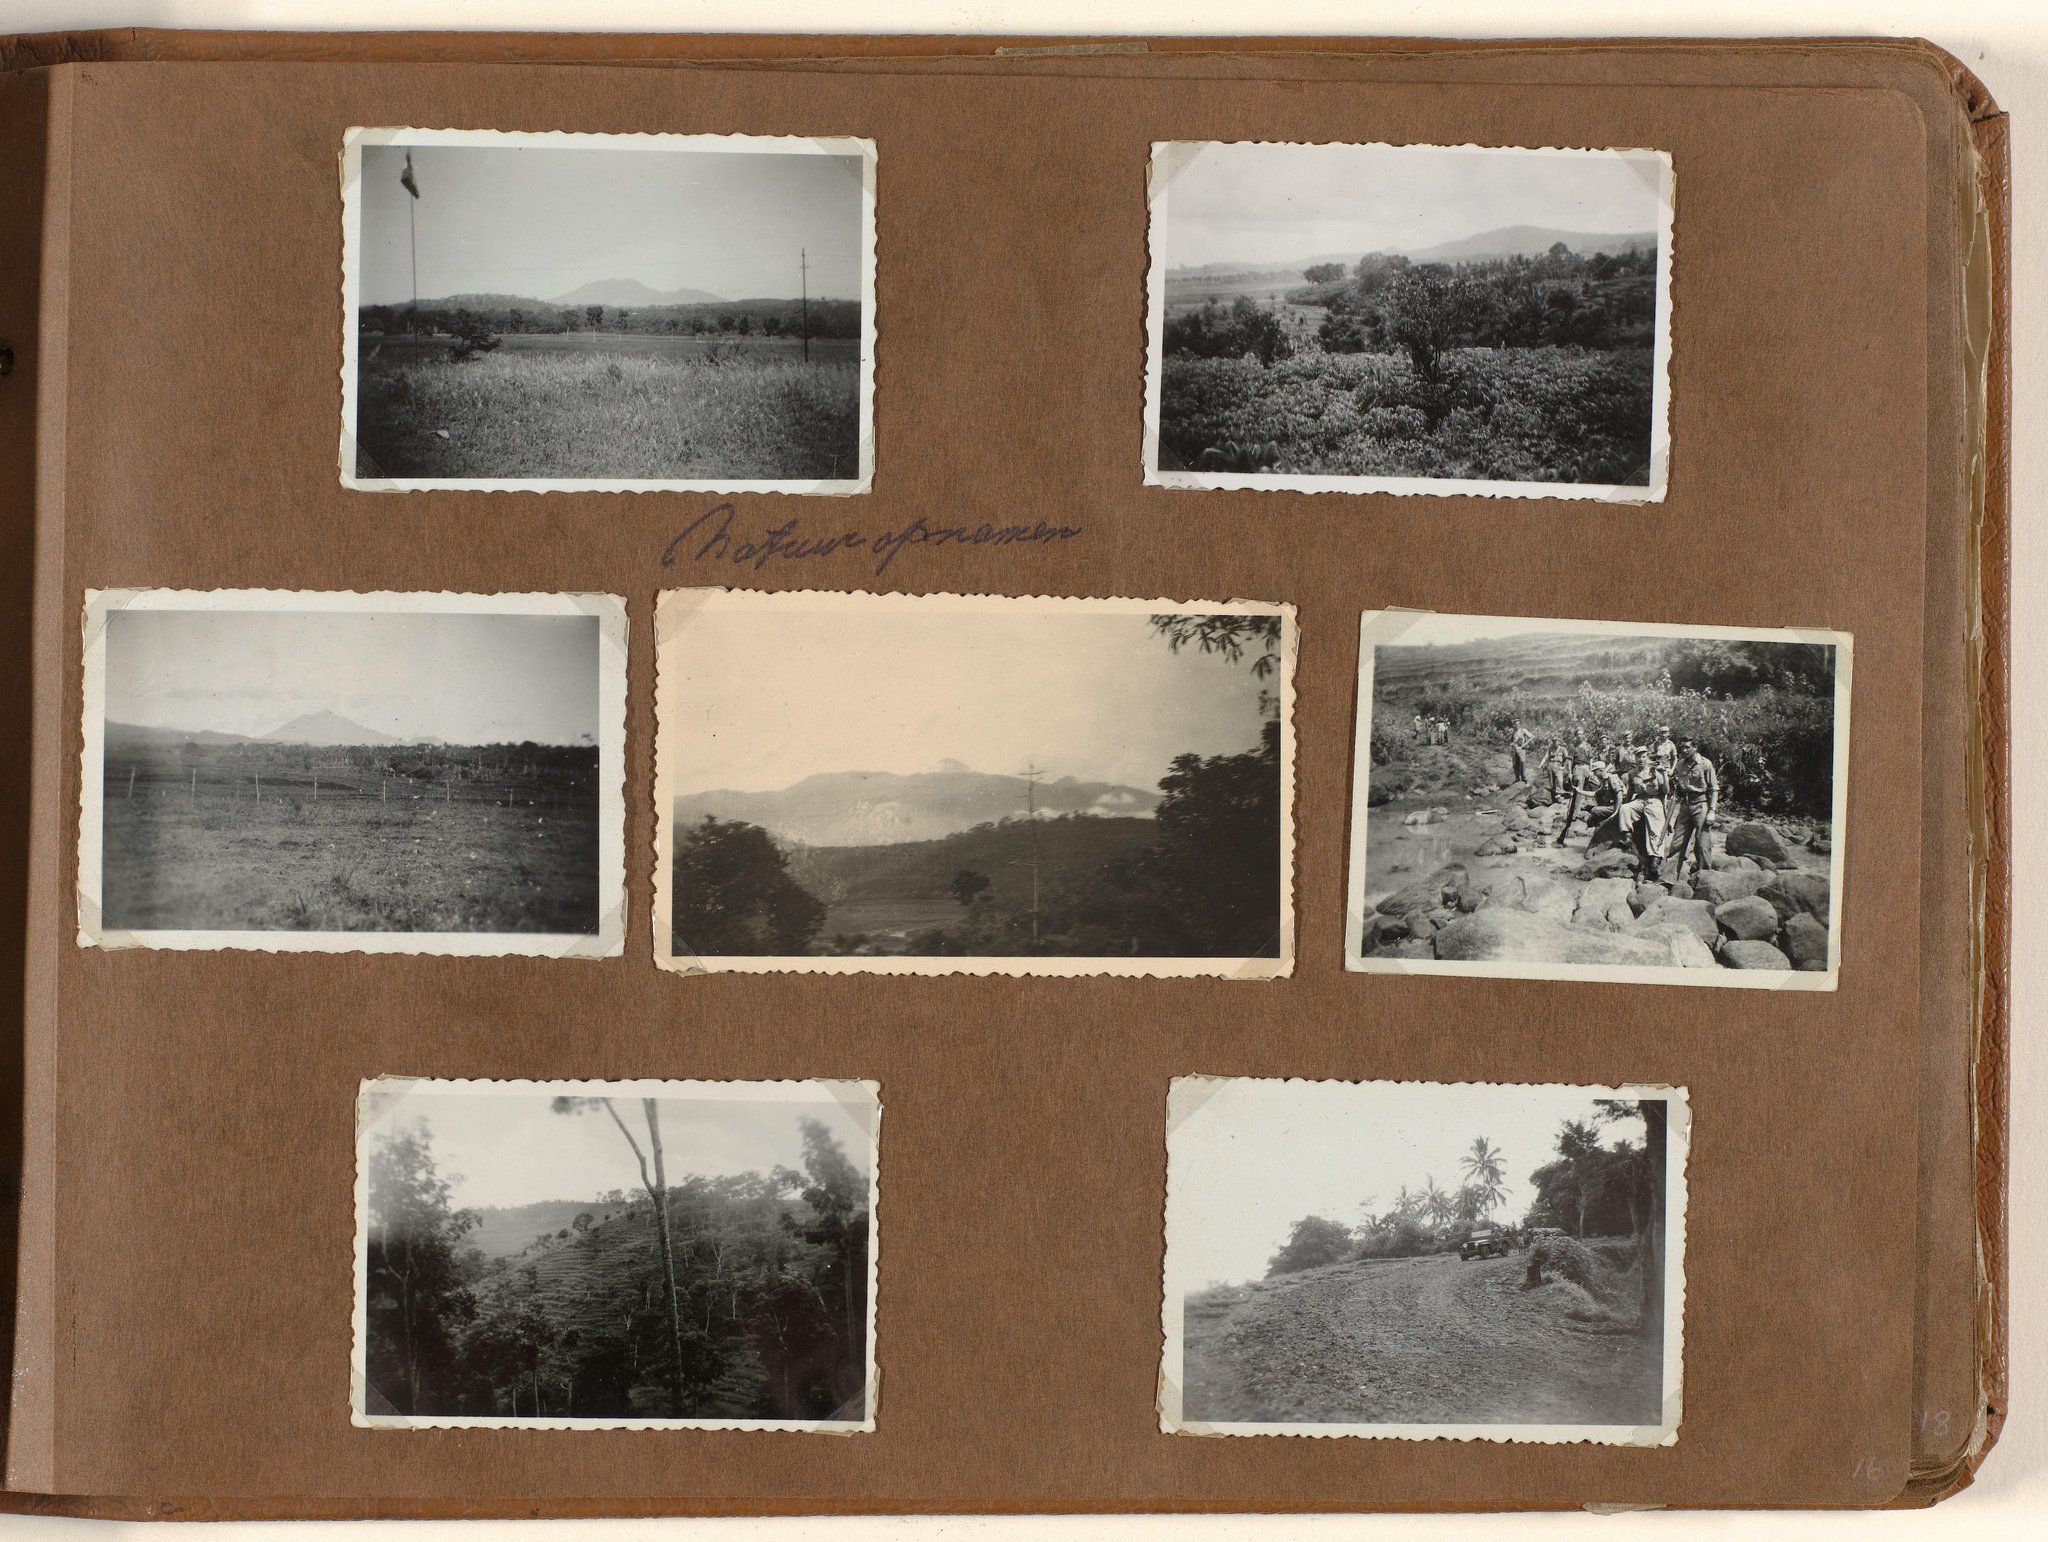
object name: album leaf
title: Natuuropnamen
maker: Anonymous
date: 1948-1949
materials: paper, photographic support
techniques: photography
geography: central java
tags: landscapes in tropical and sub-tropical regions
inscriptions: annotation: ‘Natuuropnamen’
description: Albumblad met zeven foto's. Verschillende opnamen van natuur, zoals bergen, bomen, vulkanen, dieren, boeren die op het land werken. Ook twee foto's met Nederlandse militairen op patrouille.